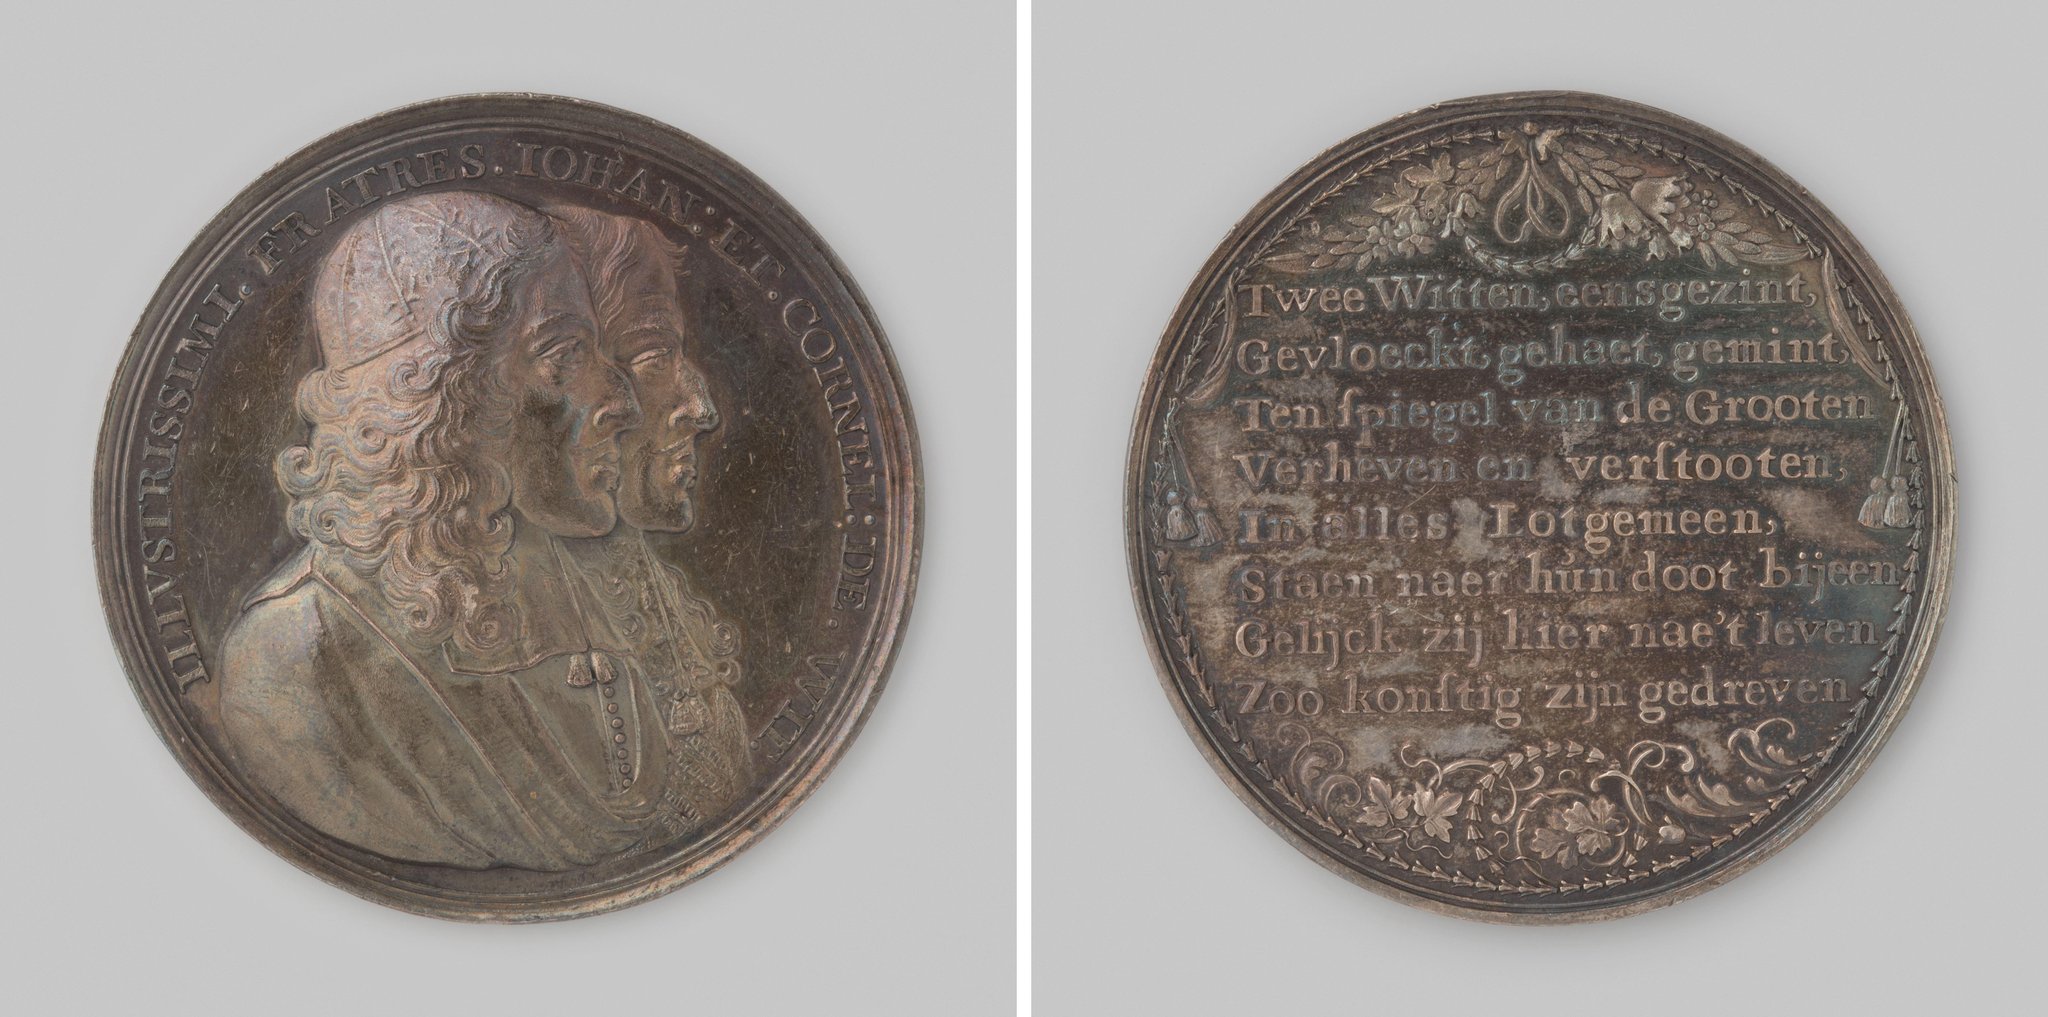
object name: history medal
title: Johan en Cornelis de Witt vermoord in 's-Gravenhage 1672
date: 1672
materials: silver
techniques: striking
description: Zilveren penning, op de voorzijde de geconjugeerde borstbeelden van Johan en Cornelis de Witt, met omschrift, op de keerzijde acht regels tekst binnen een krans versierd met bladranken.